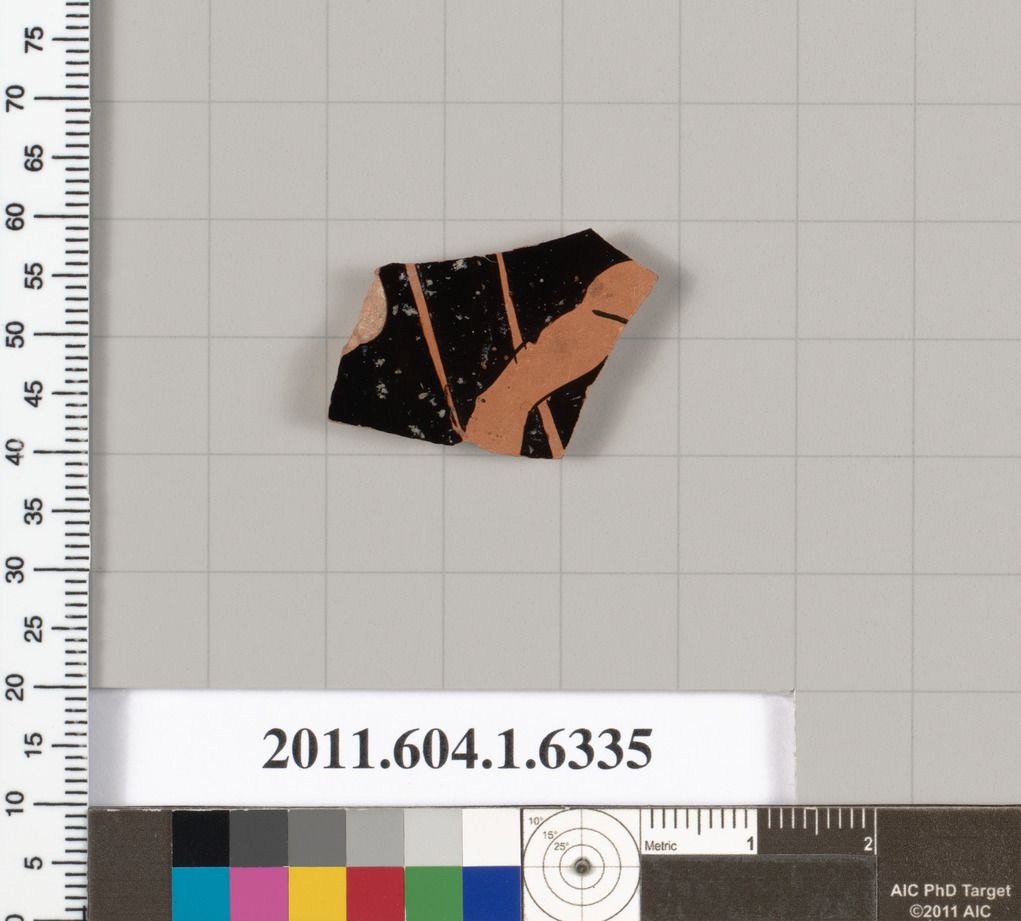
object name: kylix fragment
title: Terracotta fragment of a kylix (drinking cup)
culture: greek, attic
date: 500-480 BCE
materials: terracotta